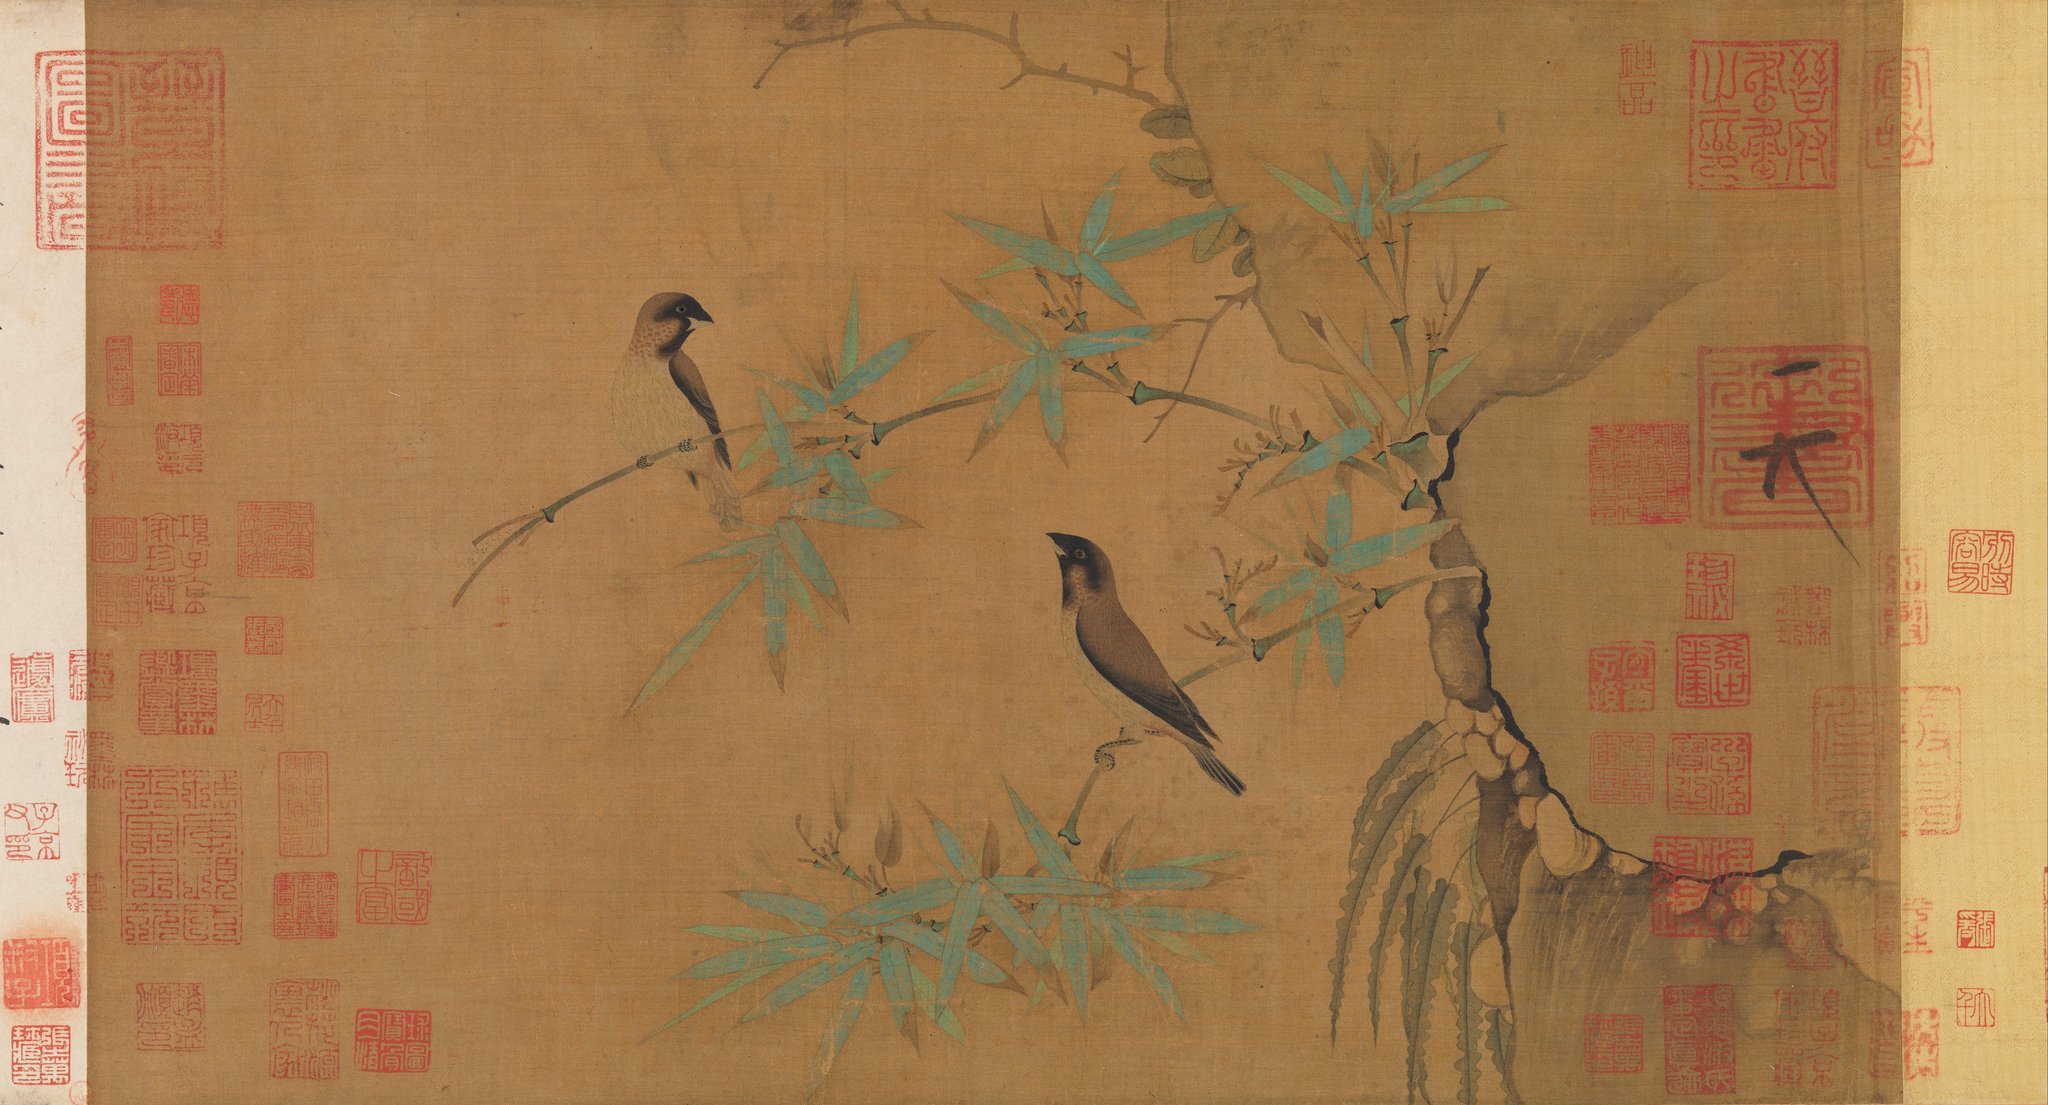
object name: handscroll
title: Finches and bamboo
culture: chinese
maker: emperor huizong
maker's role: artist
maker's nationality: chinese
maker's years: 1082-1135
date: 1101-1133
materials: ink, silk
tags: birds,bamboo